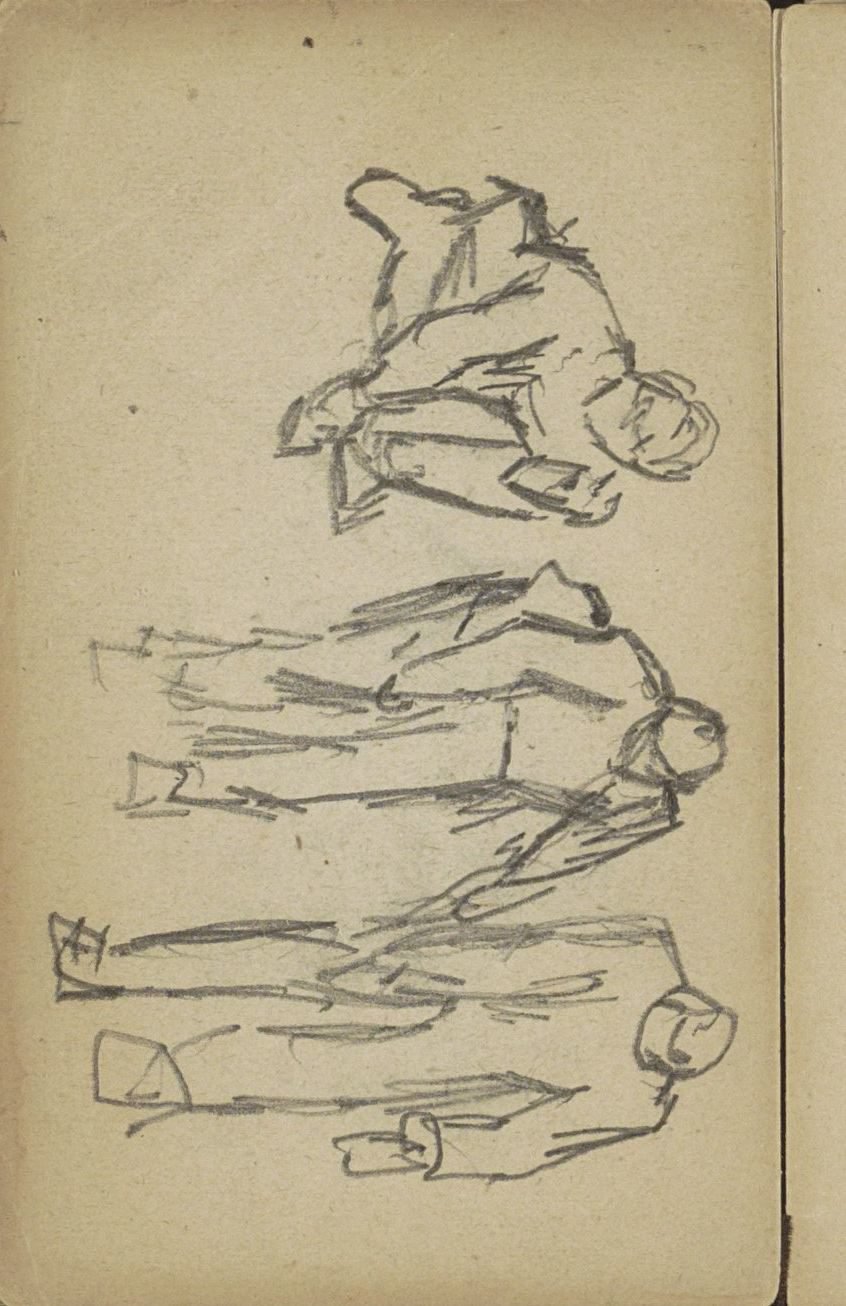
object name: sketchbook leaf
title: Twee lopende figuren en één hurkende figuur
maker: johan hendrik weissenbruch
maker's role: draughtsman, painter, print maker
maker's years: 1824-1903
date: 1834-1903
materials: paper, pencil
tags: walking (+ male human being (not to be used where -a- is prescribed)), squatting, crouching figure (+ male human being (not to be used where -a- is prescribed))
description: Blad 3 verso uit een schetsboek met 32 bladen.